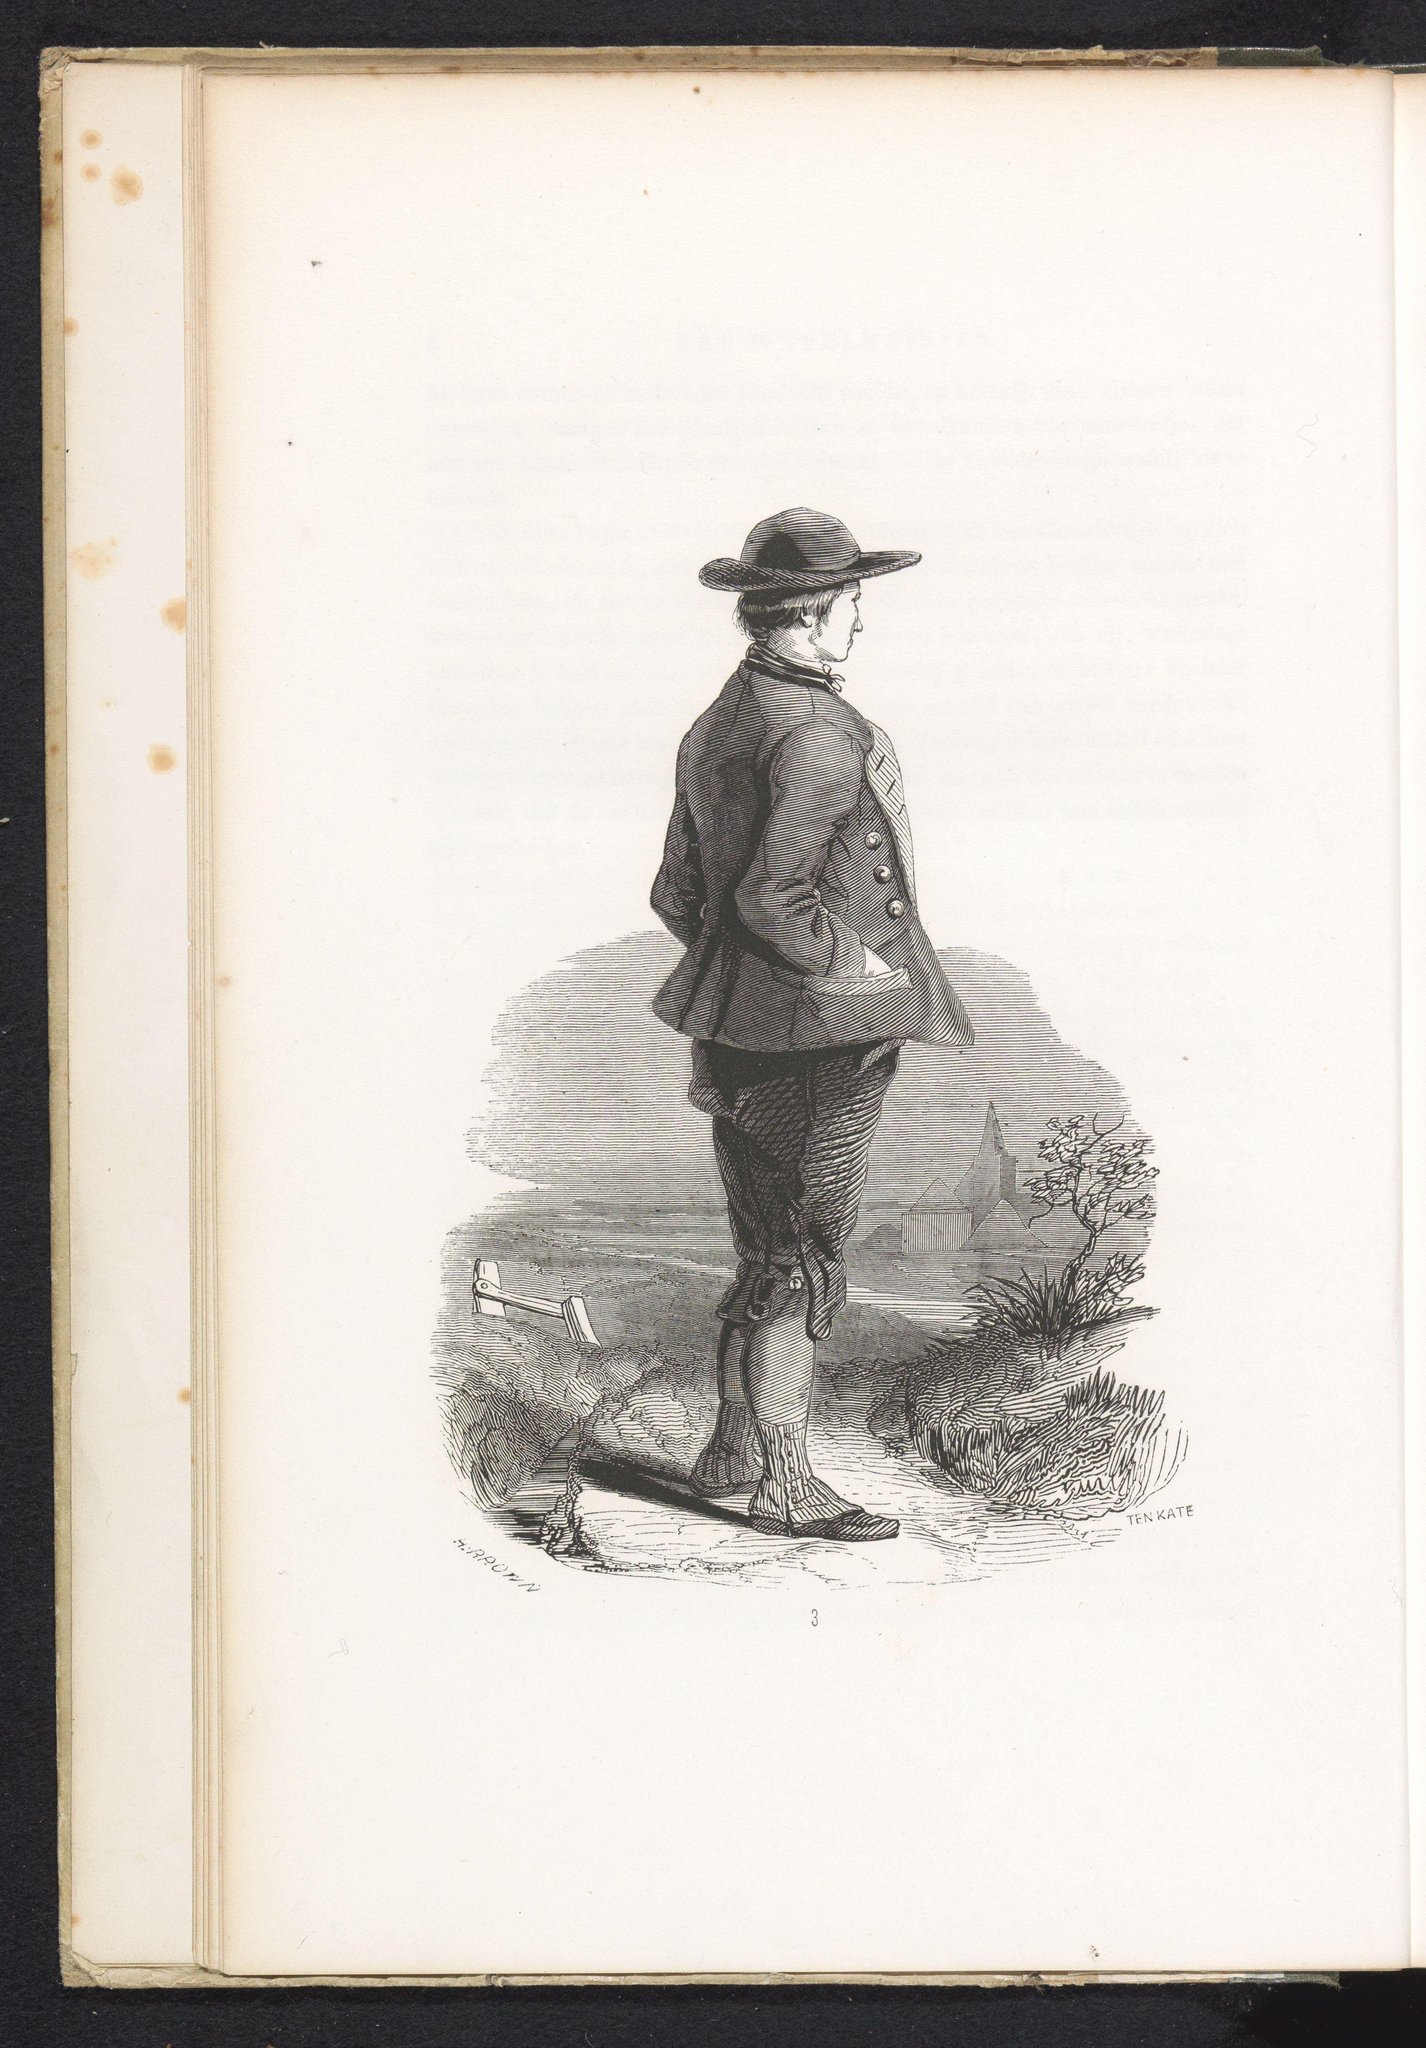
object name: book illustration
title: De Zeeuwse arbeider, 1840-1841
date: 1841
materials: paper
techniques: letterpress printing, engraving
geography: the hague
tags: professional clothes, working class, labourers, zeeland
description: Een staande jonge man, Zeeuwse arbeider, in landschap. Genummerd: 3. Illustratie in het boek 'De Nederlanden: karakterschetsen, kleederdrachten, houding en voorkomen van verschillende standen', een boek met karakterschetsen, beroepen en klederdrachten van Nederlandse volkstypen uit 1841.